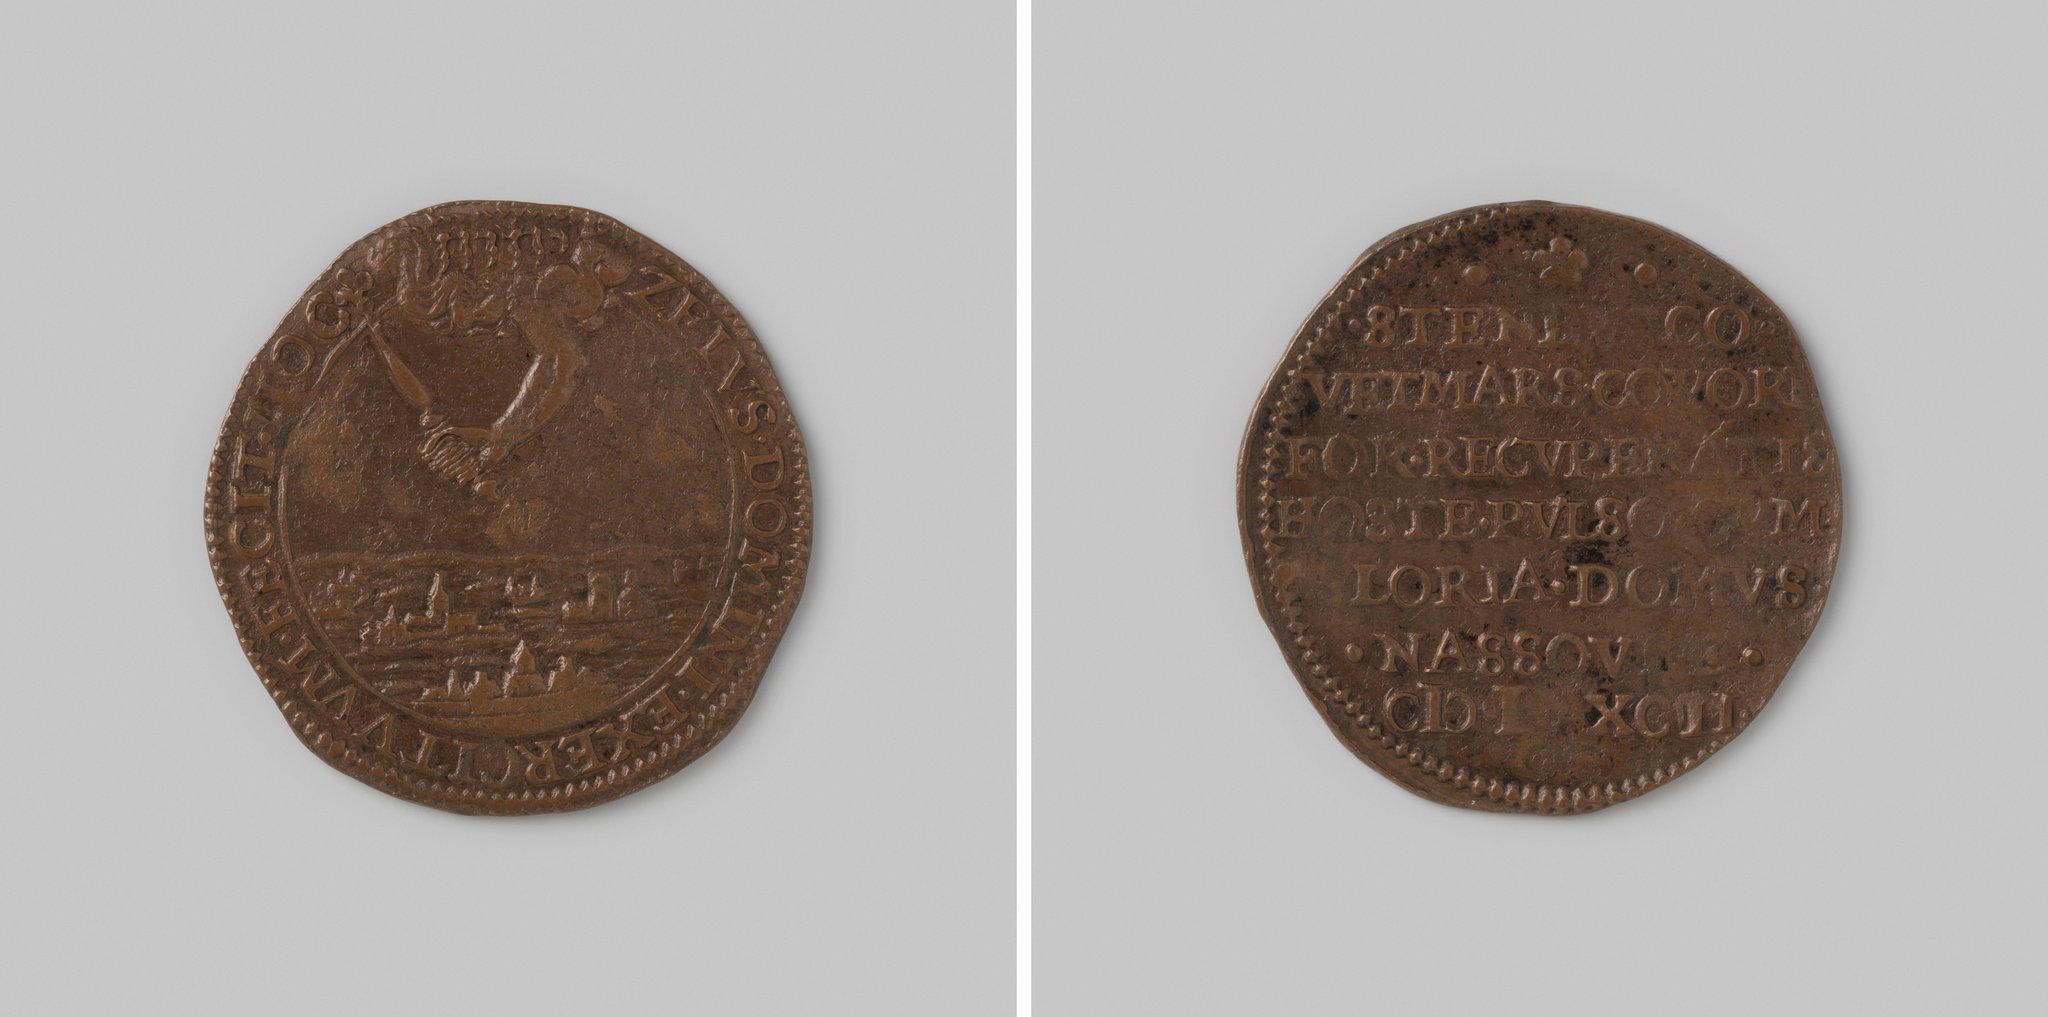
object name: history medal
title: Rekenpenning uit Dordrecht op de inname van Steenwijk, Ootmarsum en Koevorden 1592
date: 1592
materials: copper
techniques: striking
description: Koperen penning, op de voorzijde een hand met zwaard uit de wolken boven een landschap met steden, met omschrift, op de keerzijde zeven regels tekst.